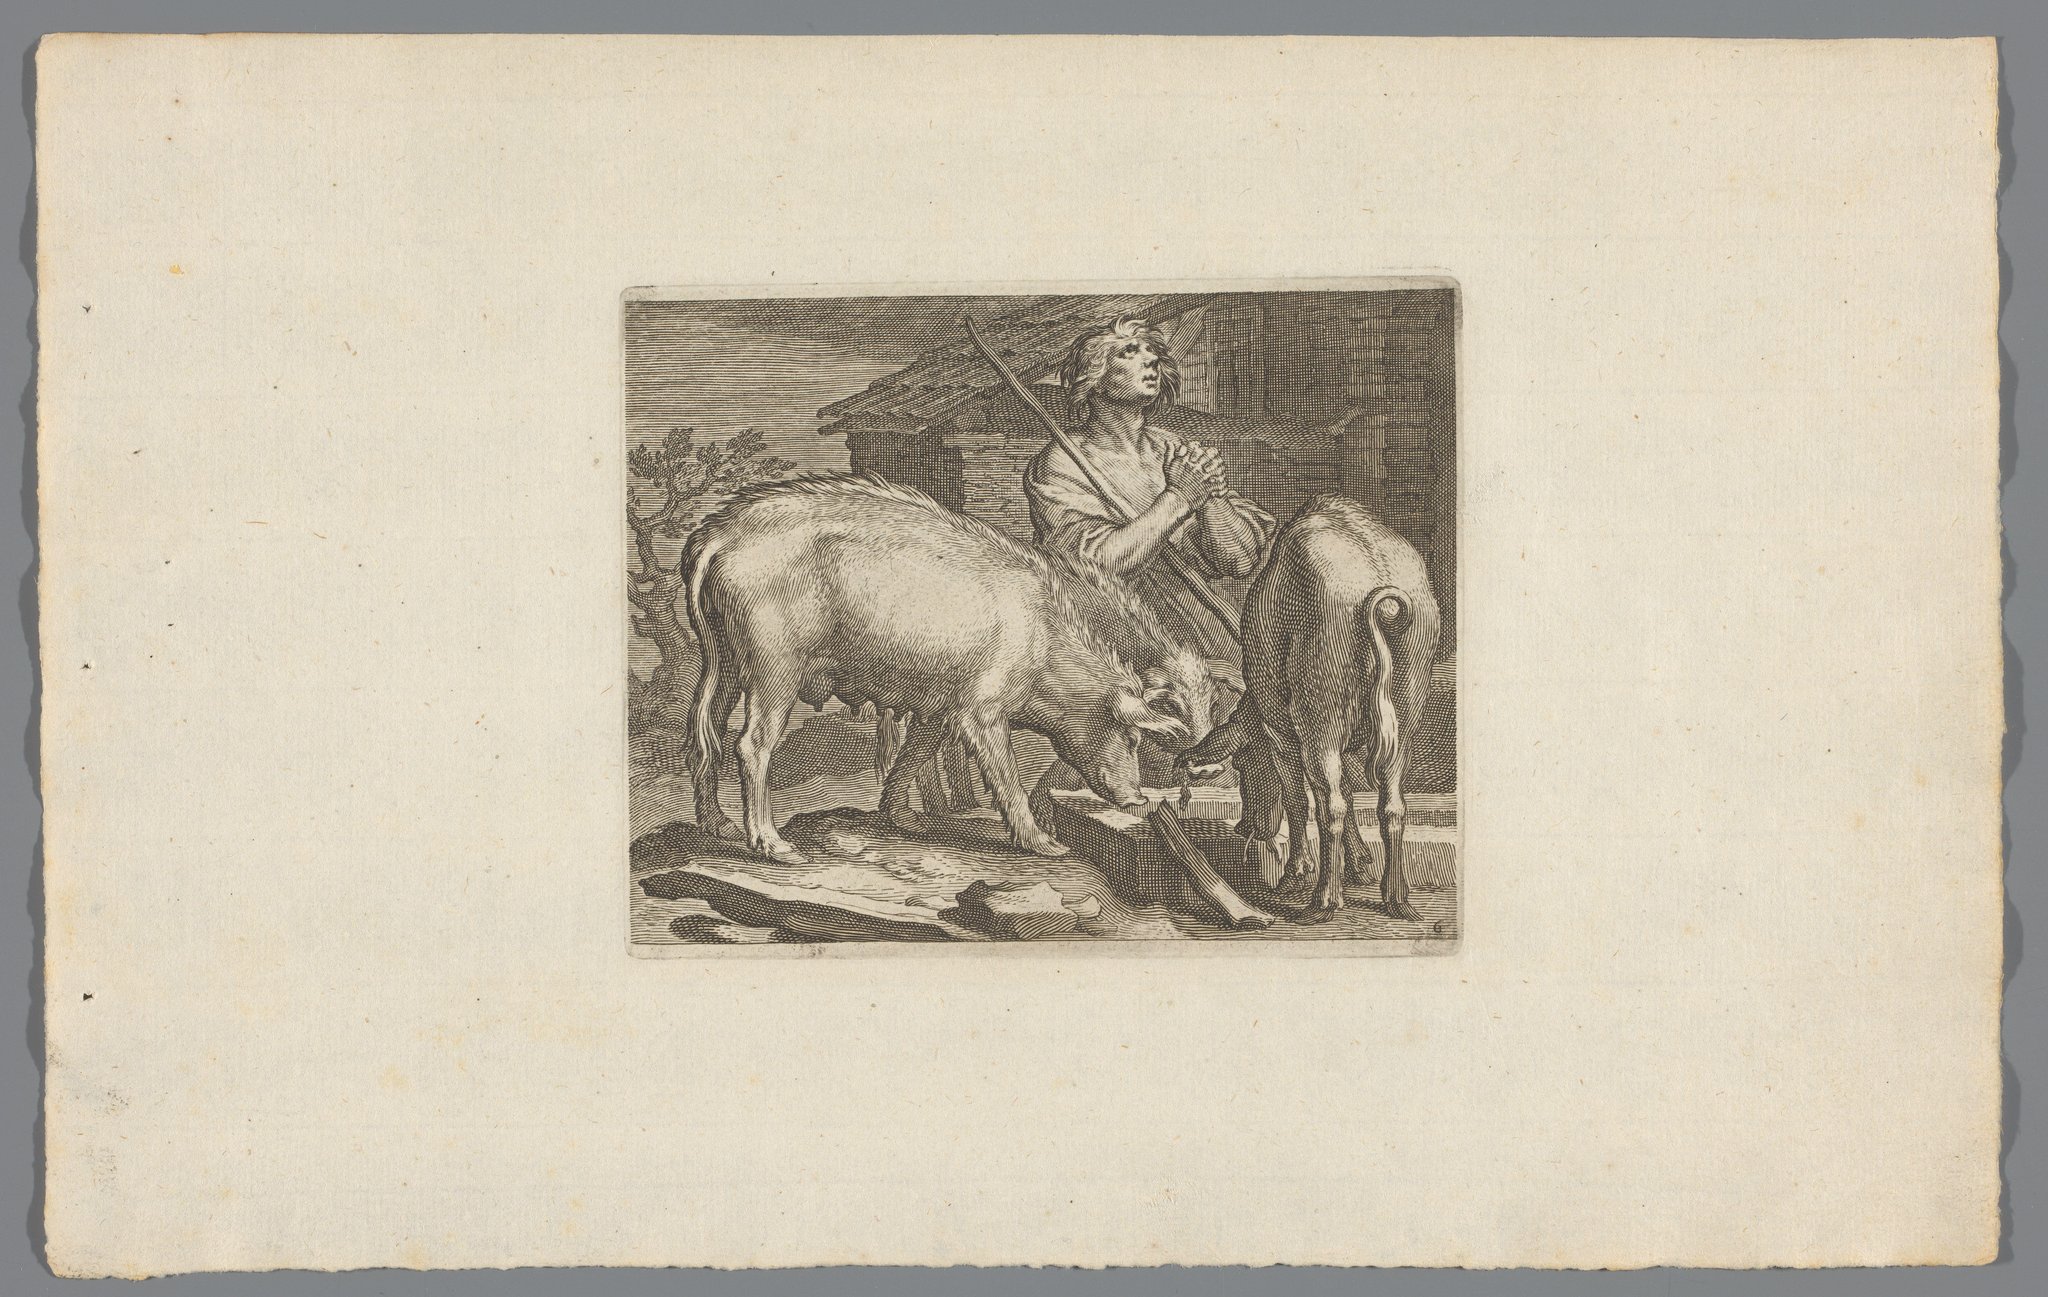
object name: print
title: Verloren zoon als varkenshoeder met varkens bij trog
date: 1611-1632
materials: paper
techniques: engraving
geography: amsterdam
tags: pig, herding, herdsman, herdswoman, shepherd, shepherdess, cowherd, etc., the parable of the prodigal son (luke 15:11-32)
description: Prent maakt deel uit van een serie van veertien prenten.